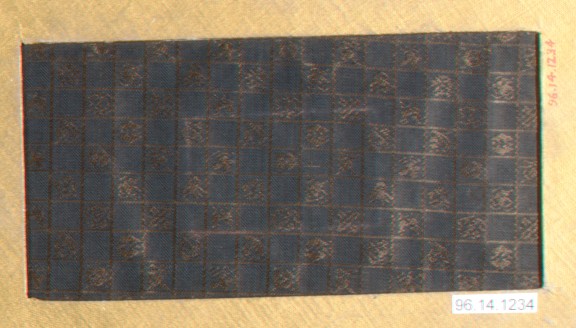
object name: piece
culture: japanese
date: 1701-1900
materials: silk